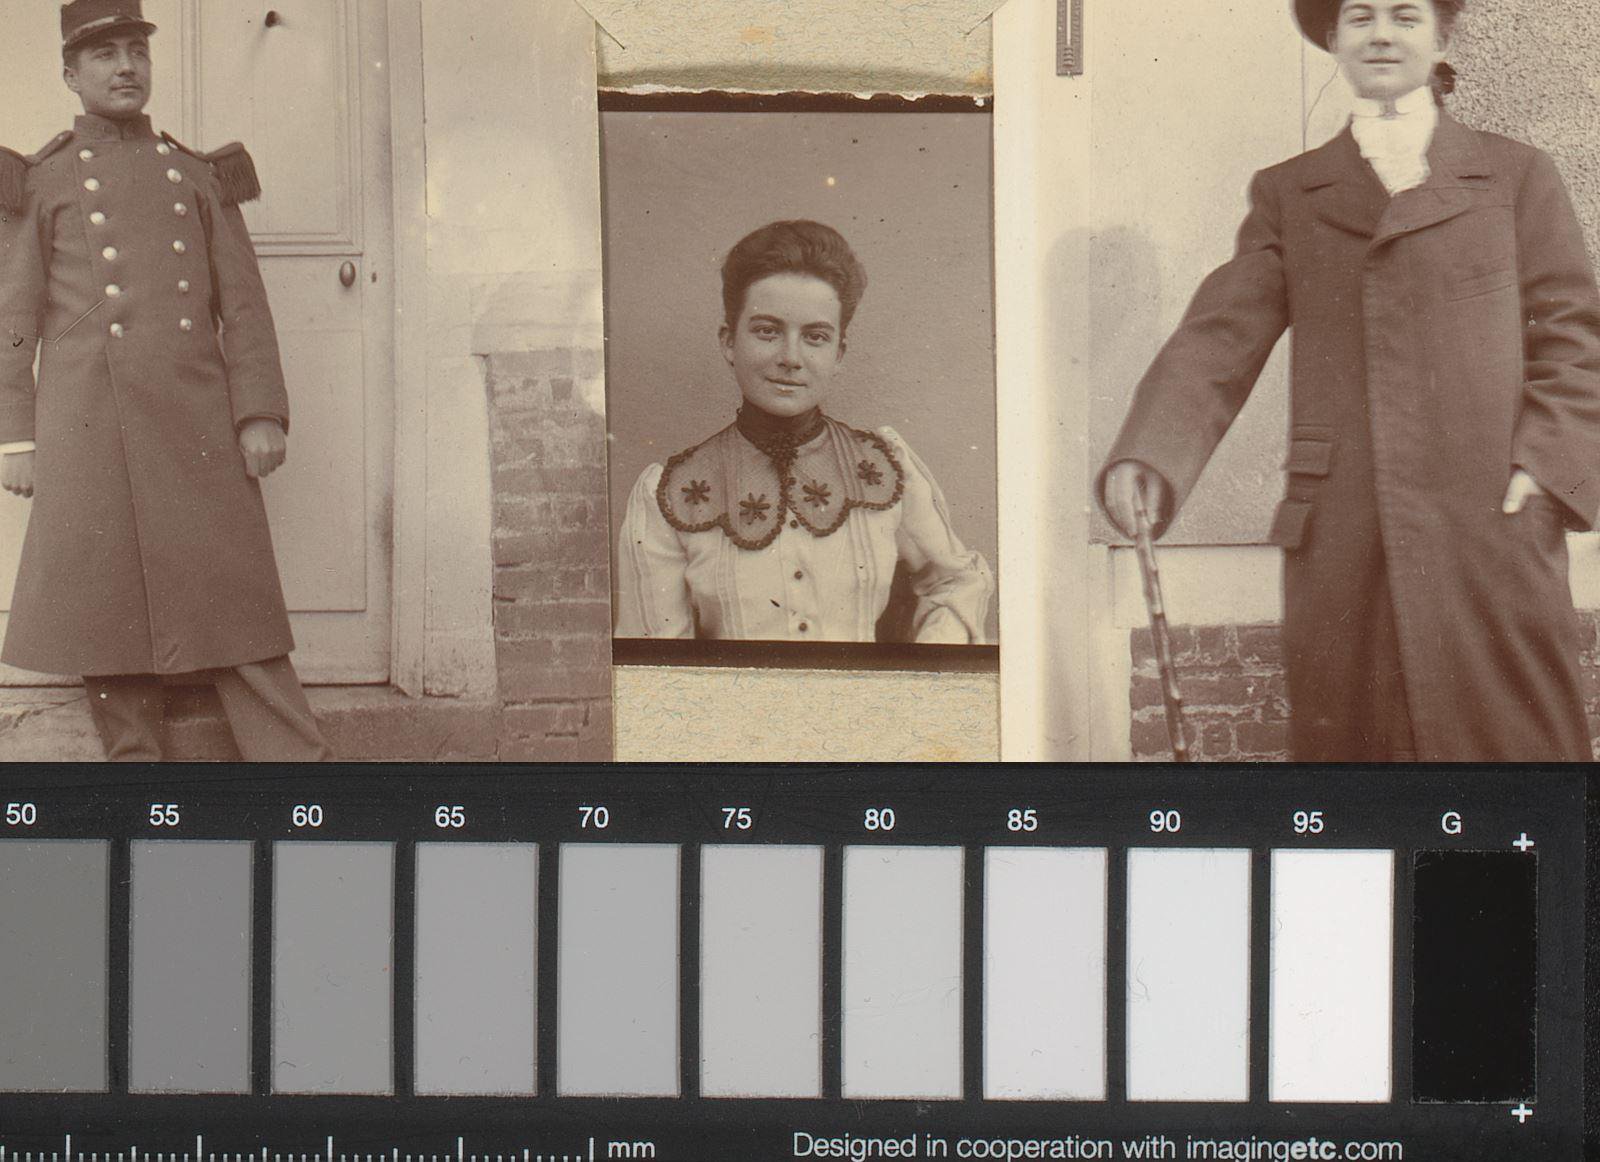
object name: album leaf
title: Portret van een jonge vrouw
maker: Anonymous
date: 1897-1900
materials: paper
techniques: gelatin silver print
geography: france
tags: adolescent, young woman, maiden, historical persons, france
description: Over de foto is een ander negatief afgedrukt van een voorstelling van bomen.